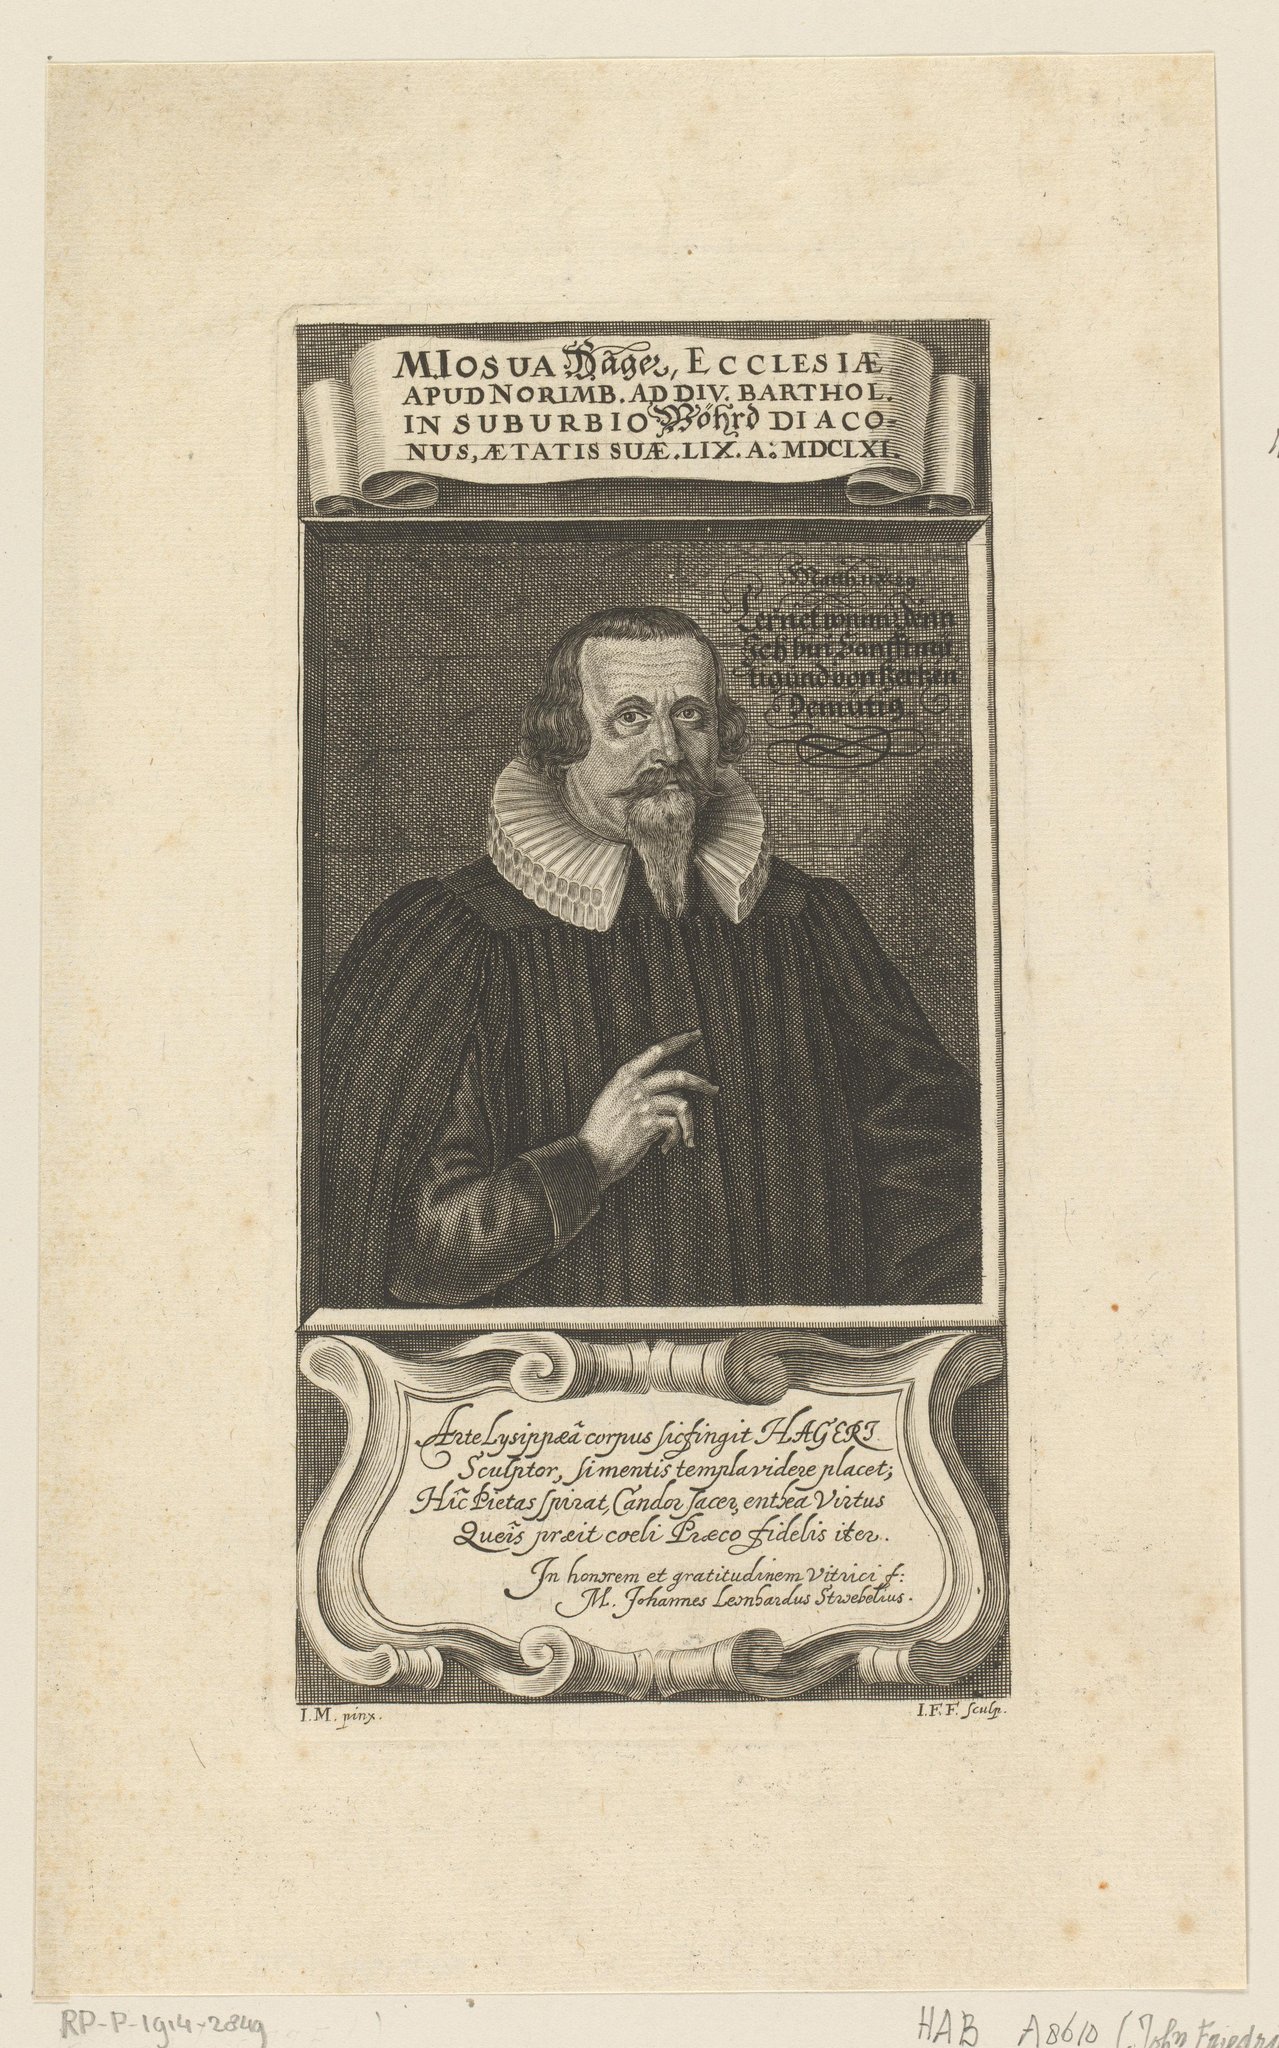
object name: print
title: Portret van Josua Hager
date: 1661-1665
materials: paper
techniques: engraving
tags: historical persons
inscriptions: watermark, collector's mark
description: Bovenaan een beschrijving van de geportretteerde. Onder het portret een Bijbelcitaat.